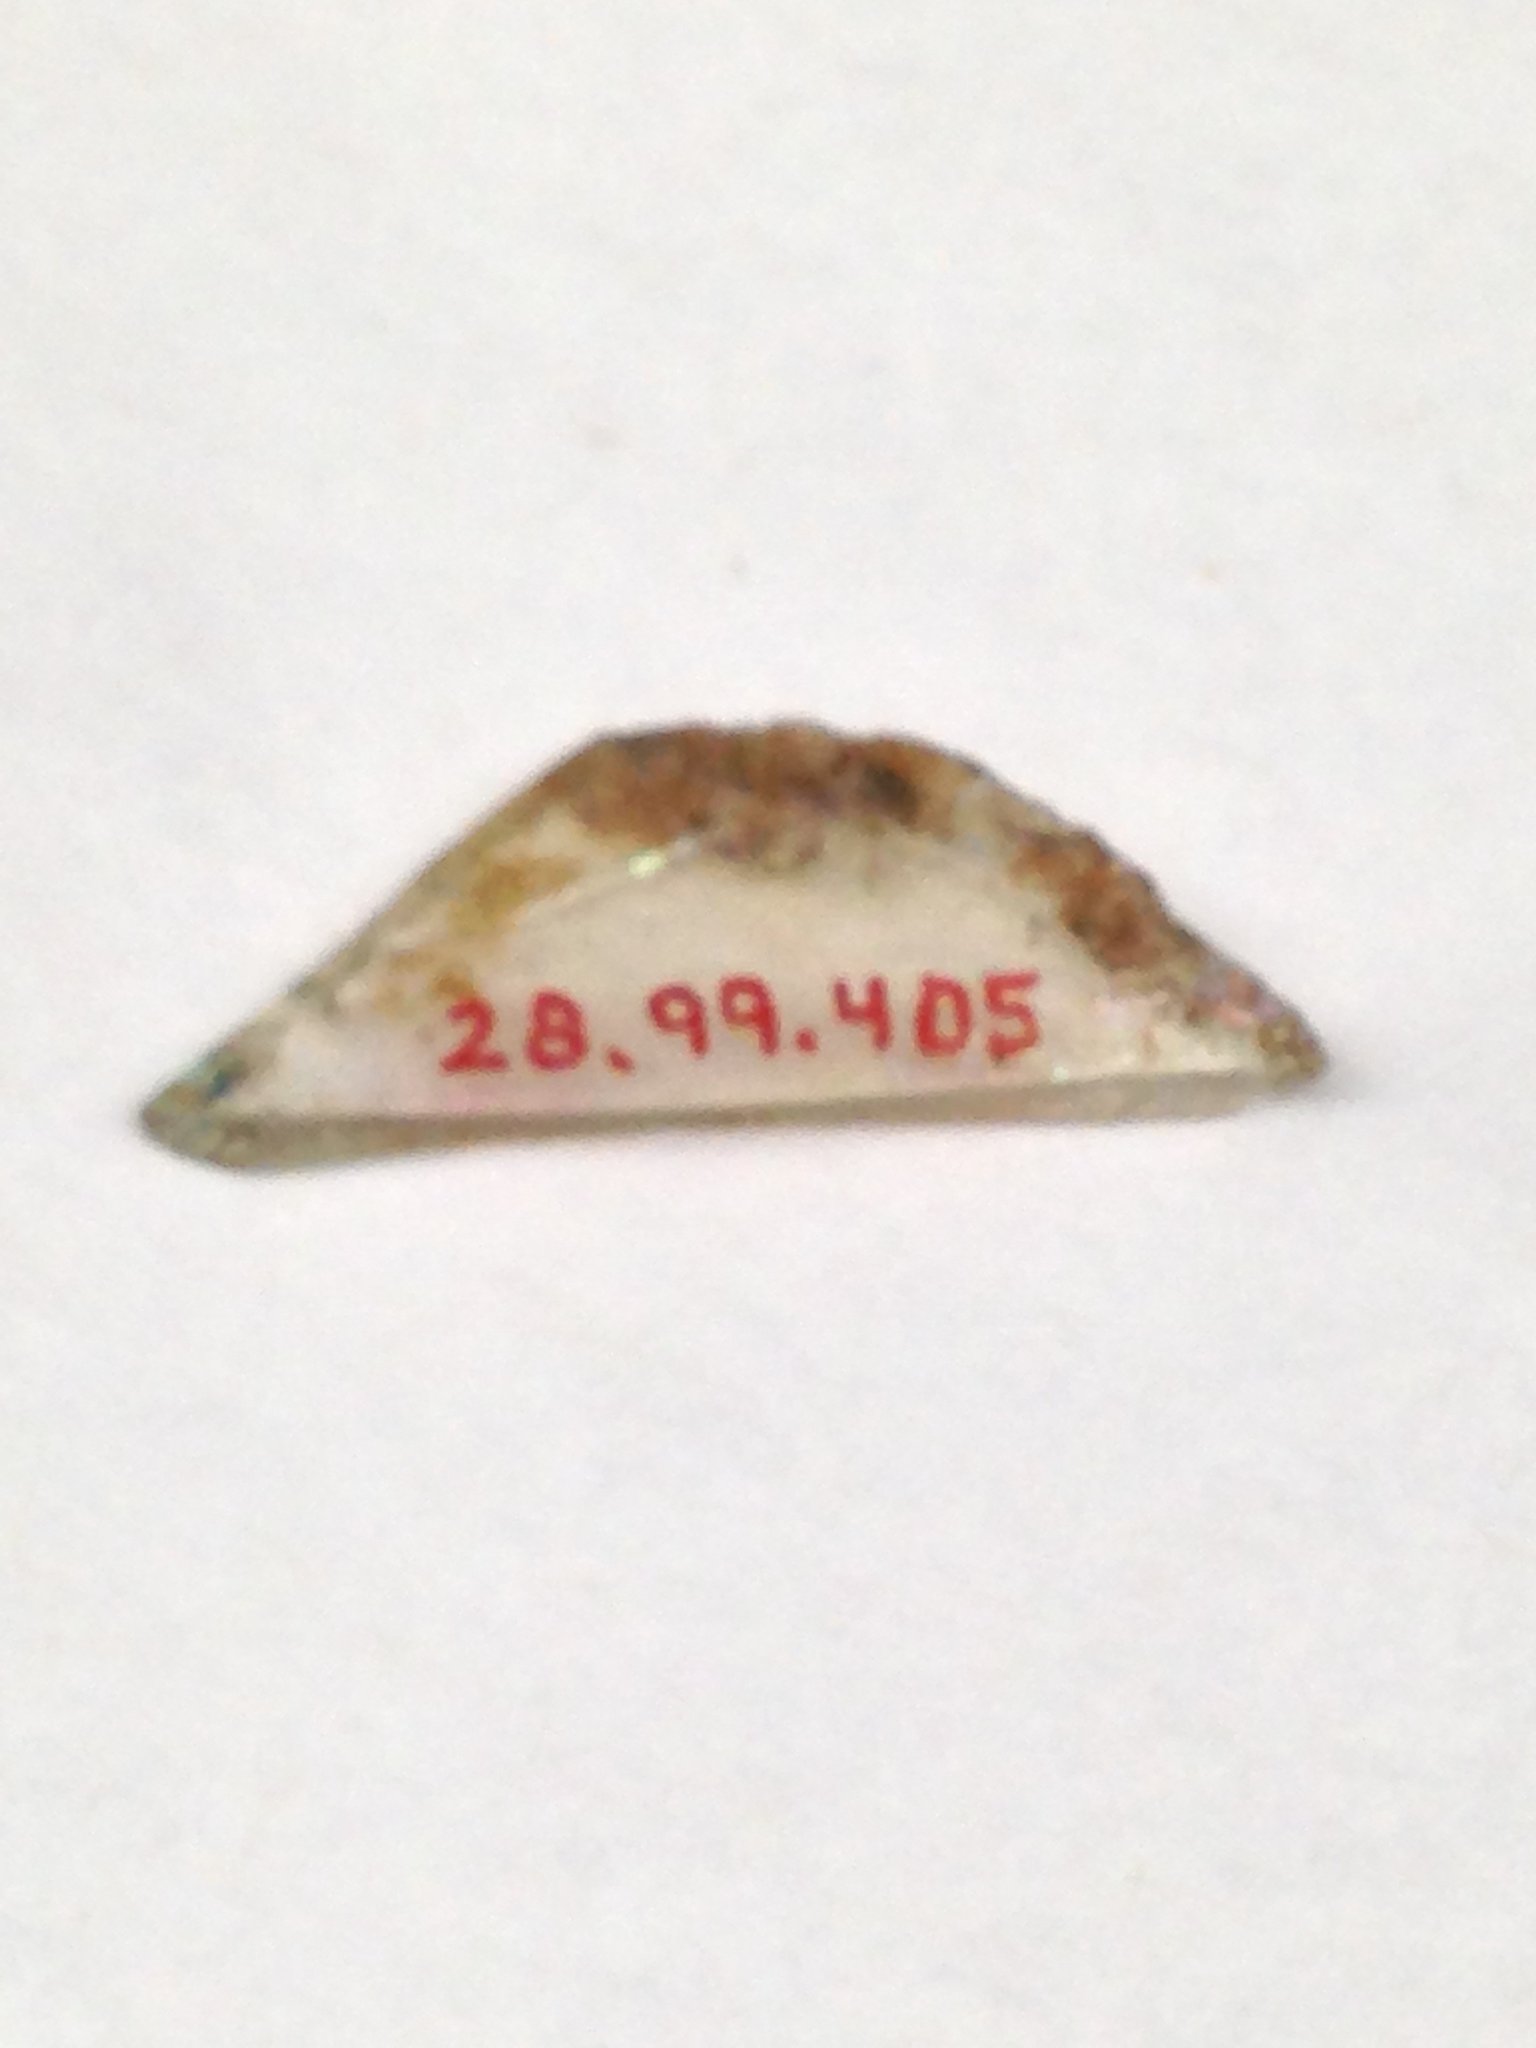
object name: fragment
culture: european or middle eastern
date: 1150-1250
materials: ceramic, glass